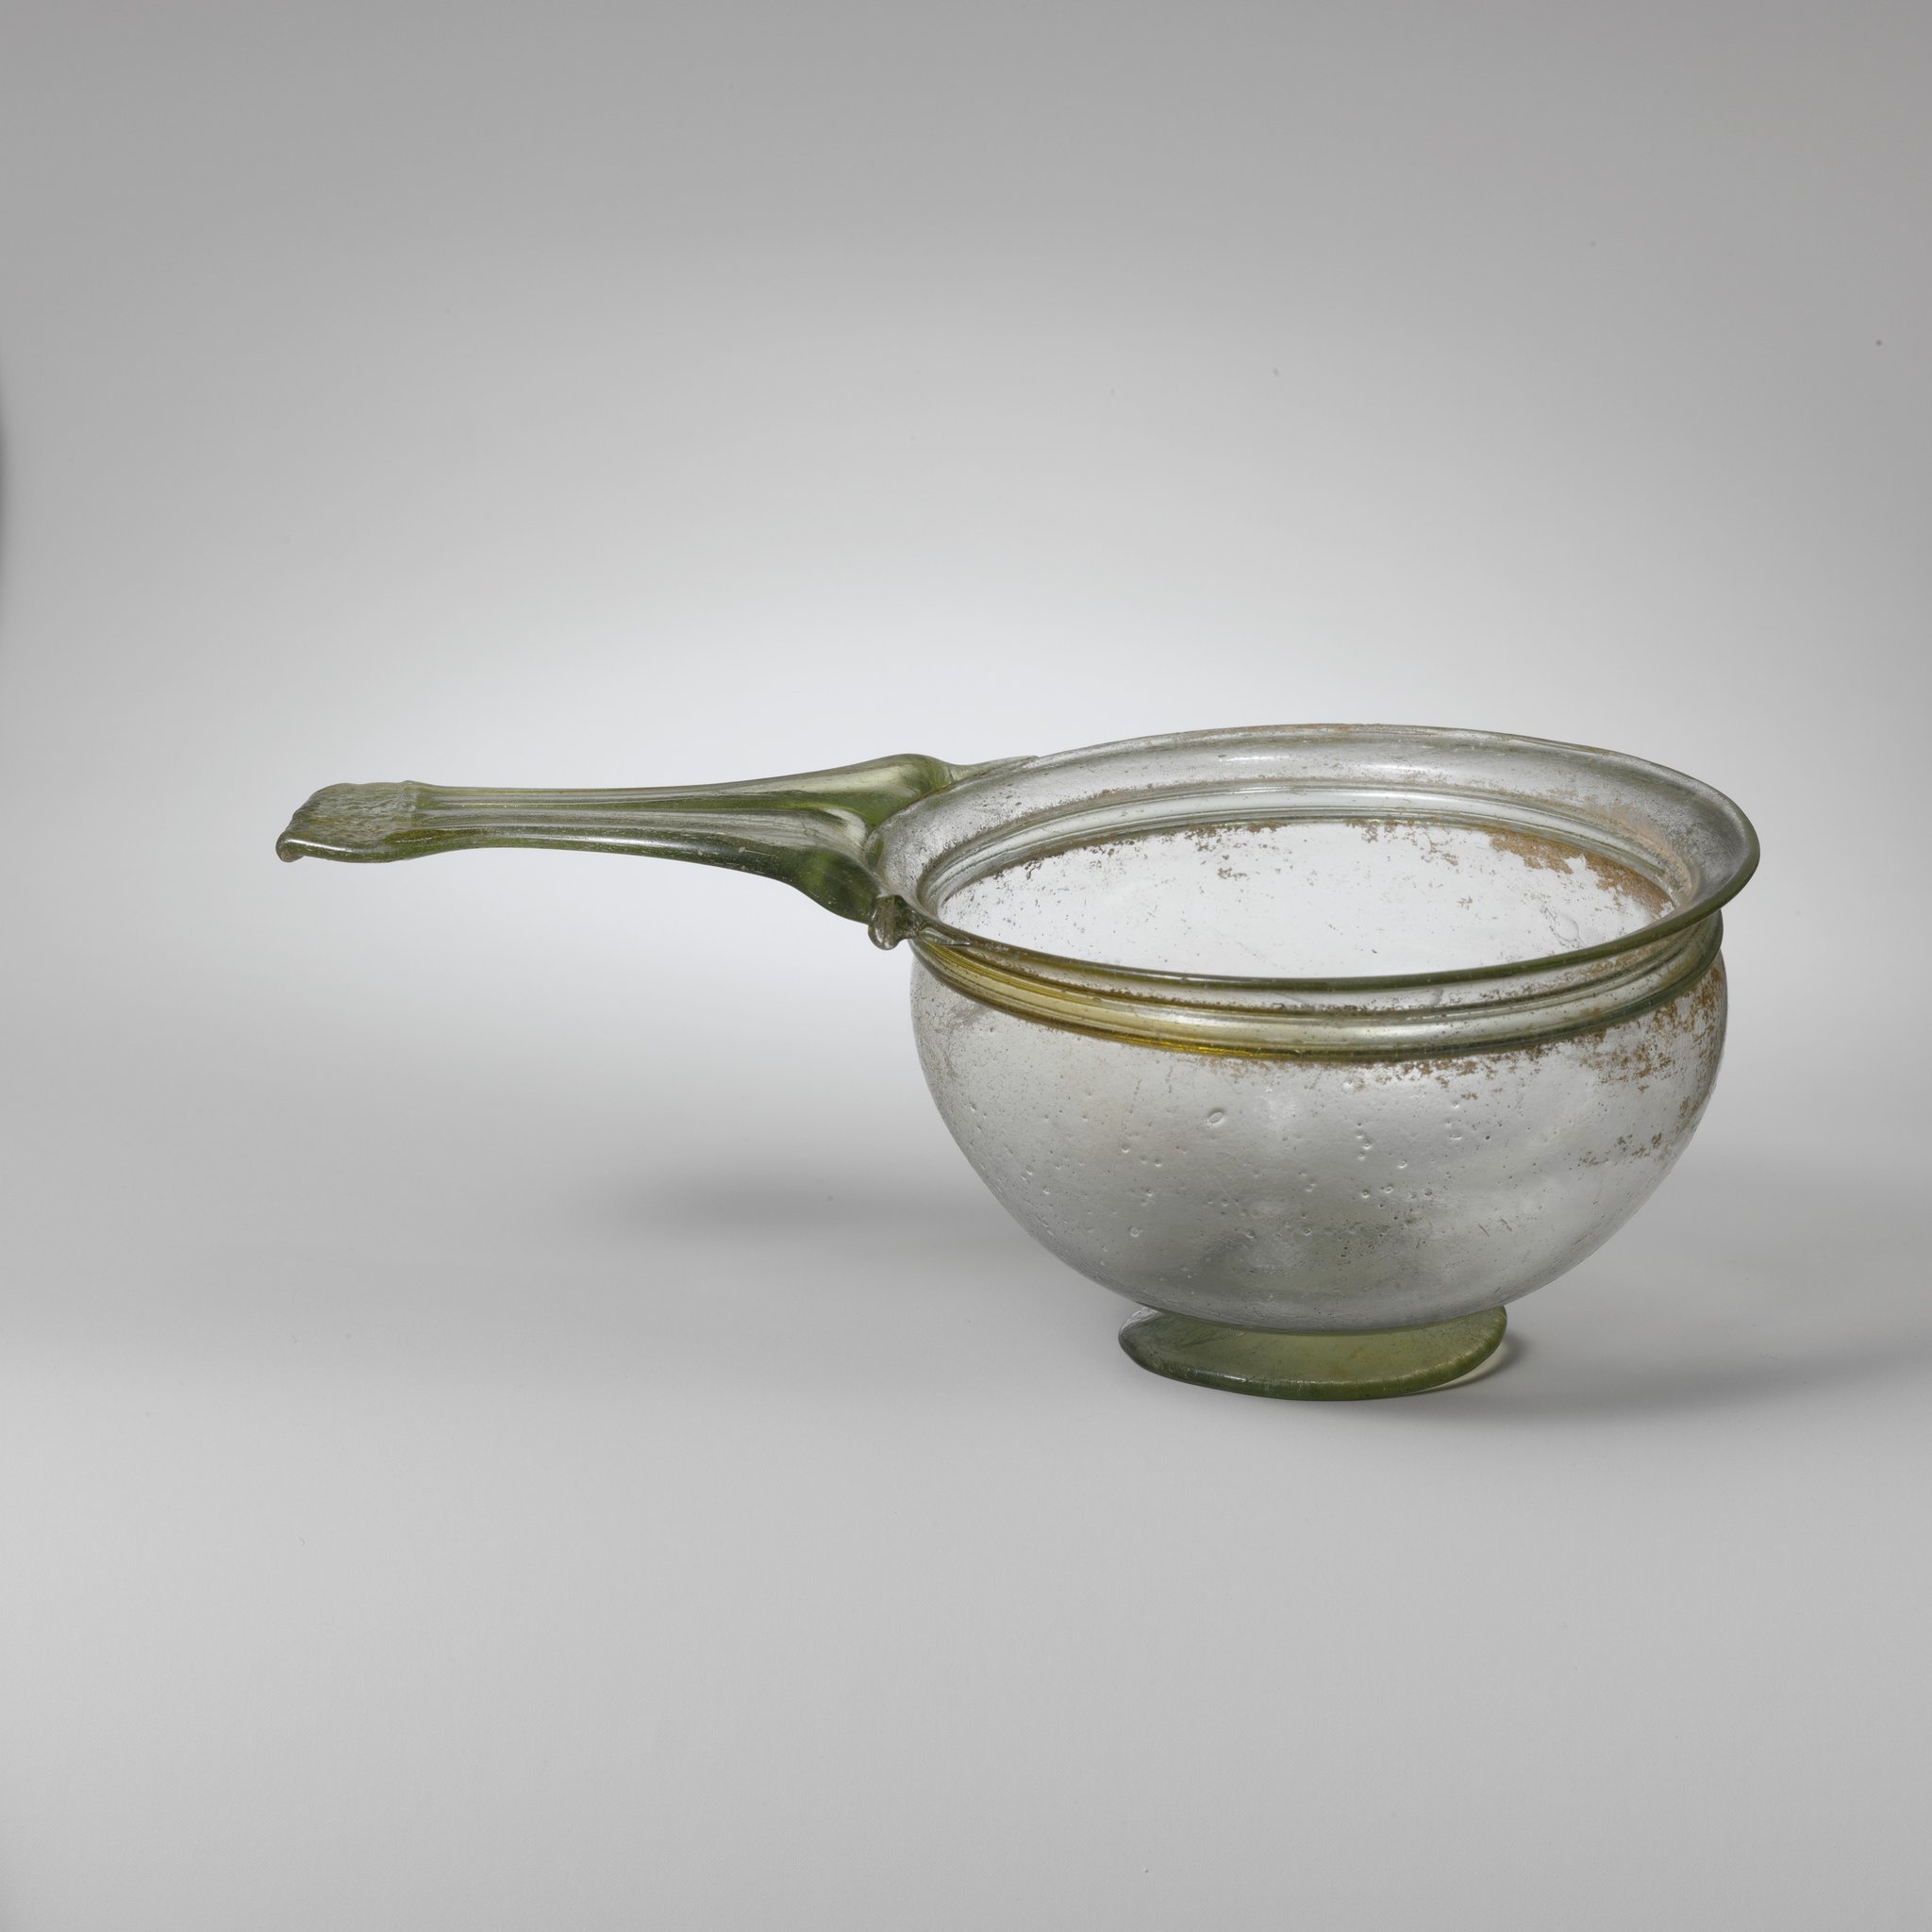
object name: trulla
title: Glass trulla (pan)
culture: roman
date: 1-400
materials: glass